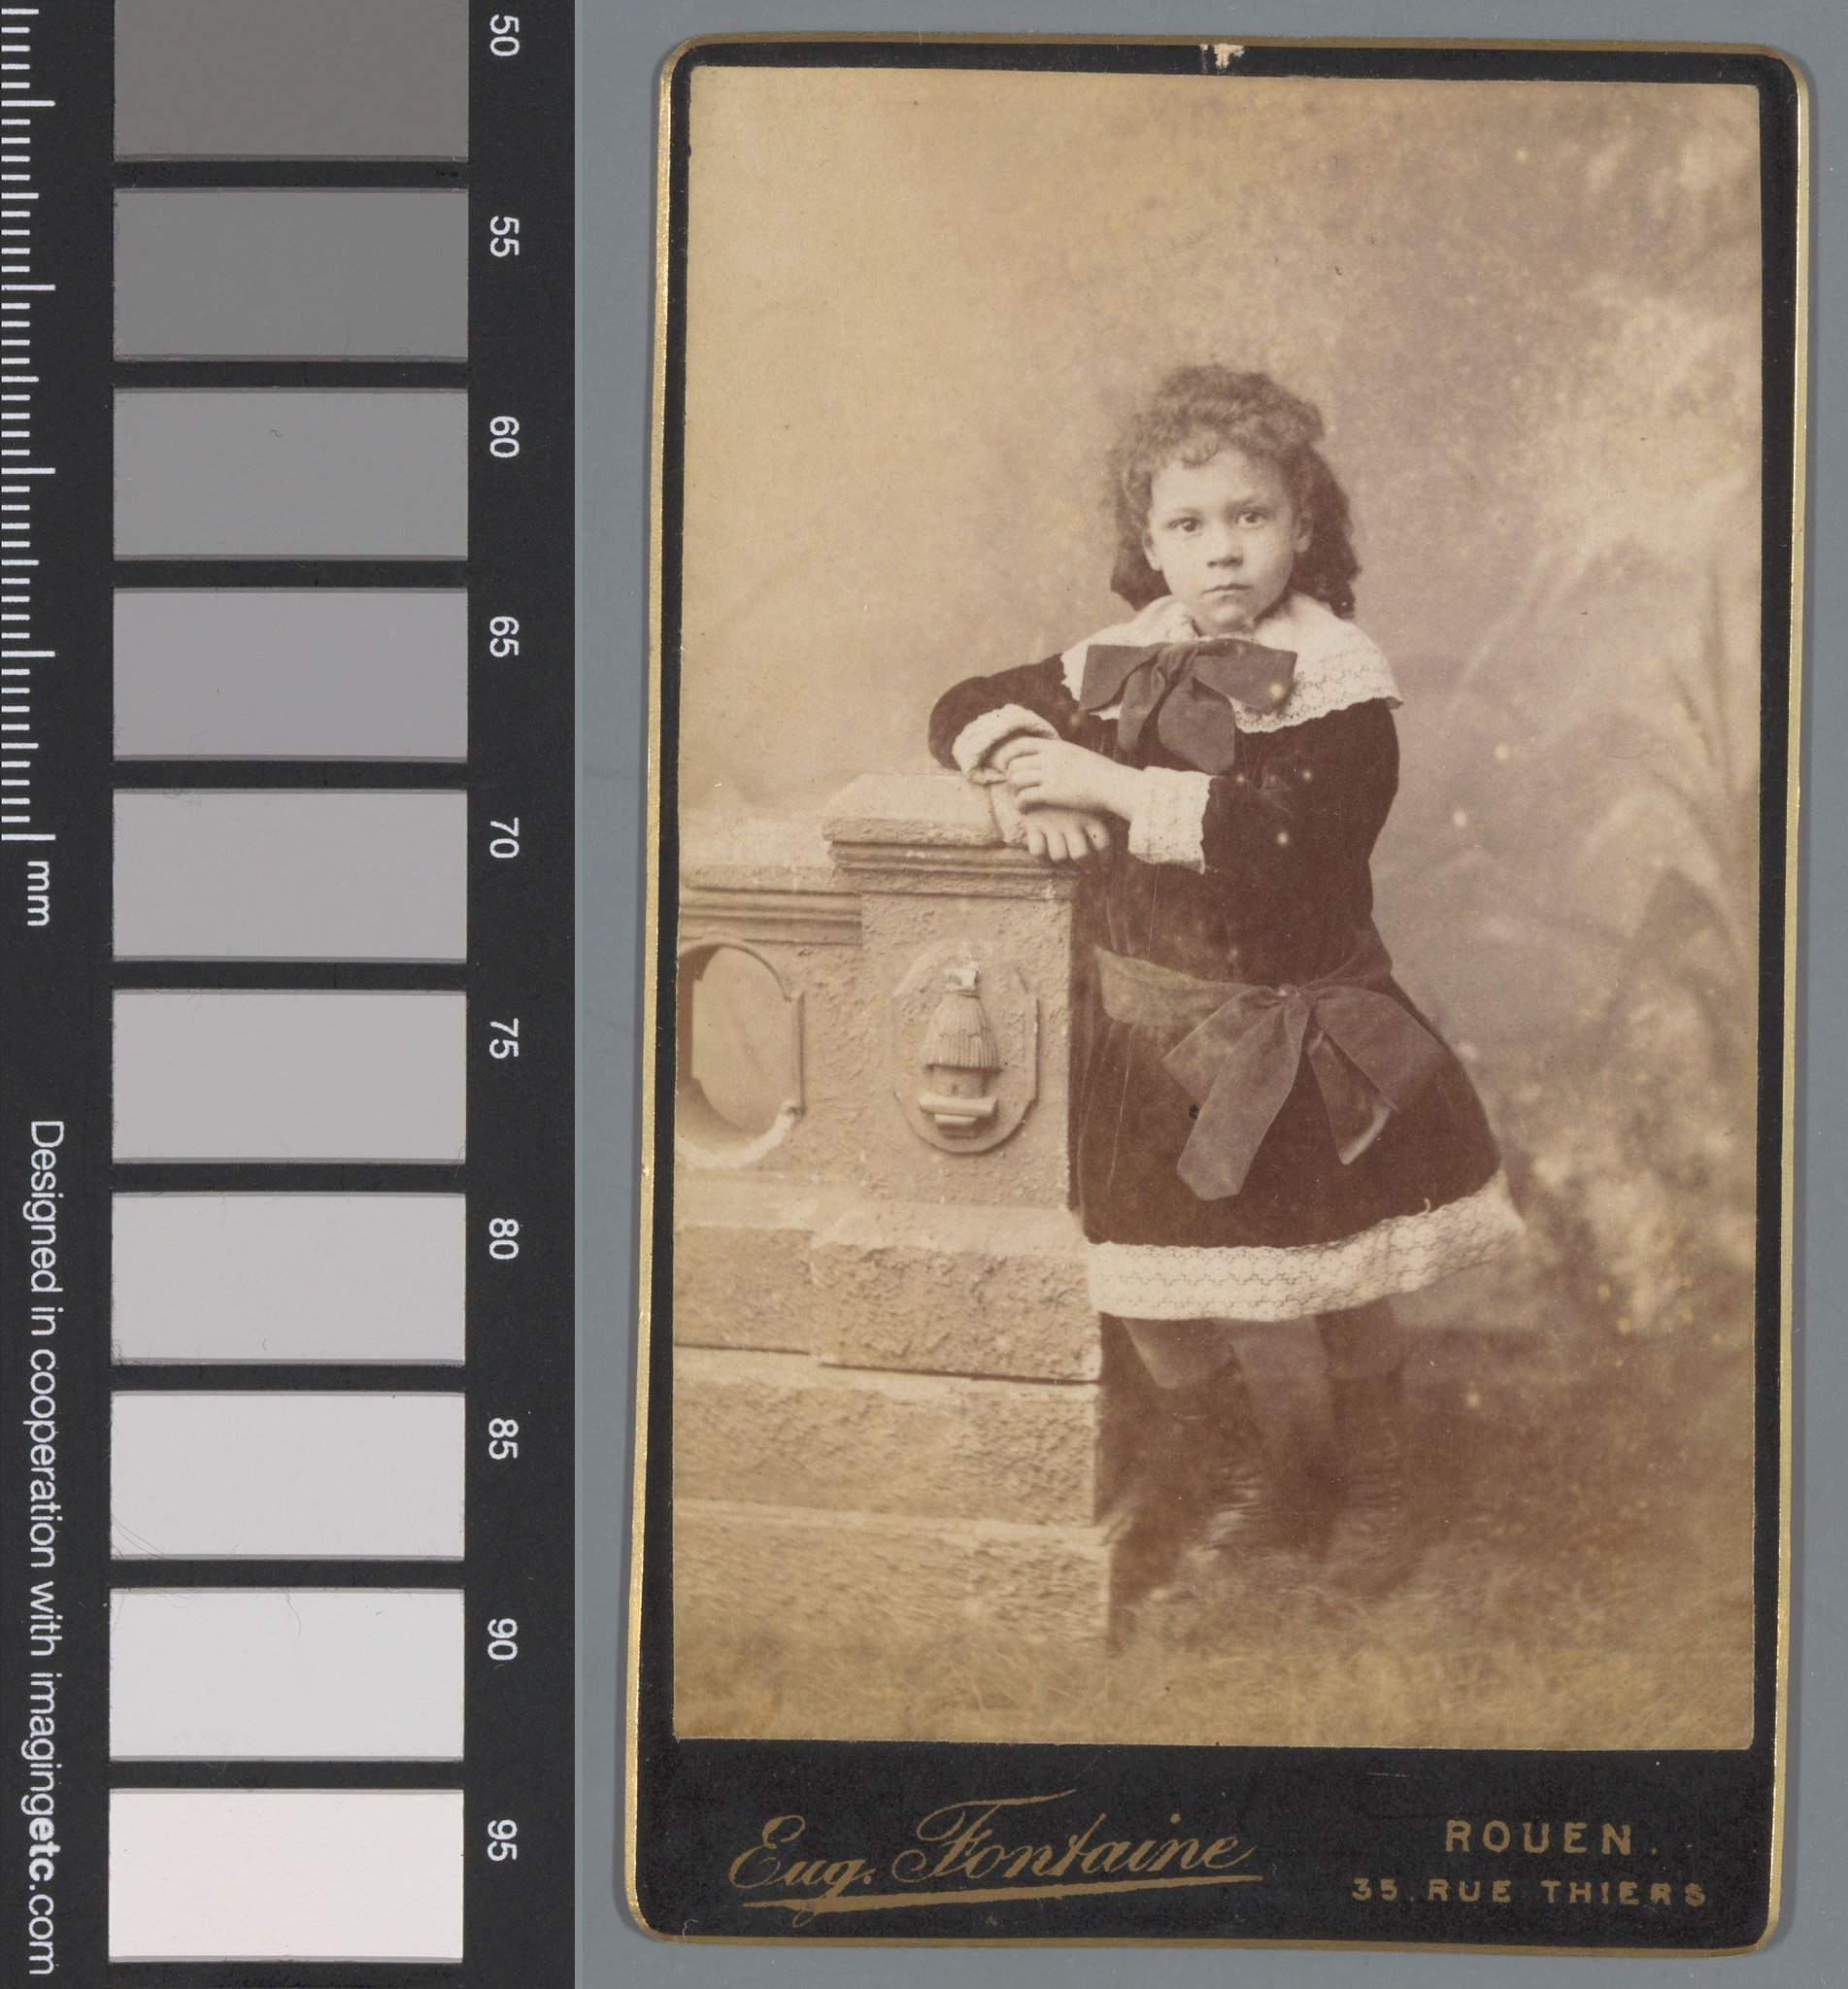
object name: carte de visite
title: Portret van een onbekend kind bij een balustrade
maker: eugène fontaine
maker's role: fotograaf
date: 1884-1902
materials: cardboard, paper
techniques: albumen print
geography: rouen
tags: child, anonymous historical person portrayed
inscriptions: inscription: ‘Eug. Fontaine Rouen./ 35, Rue Thiers’, inscription: ‘Photographie/ Renouard/ Eug. Fontaine neveu Succr./ 35 Rue Thiers/ en face le musée/ Rouen/ Atelier spécial pour les enfants.’